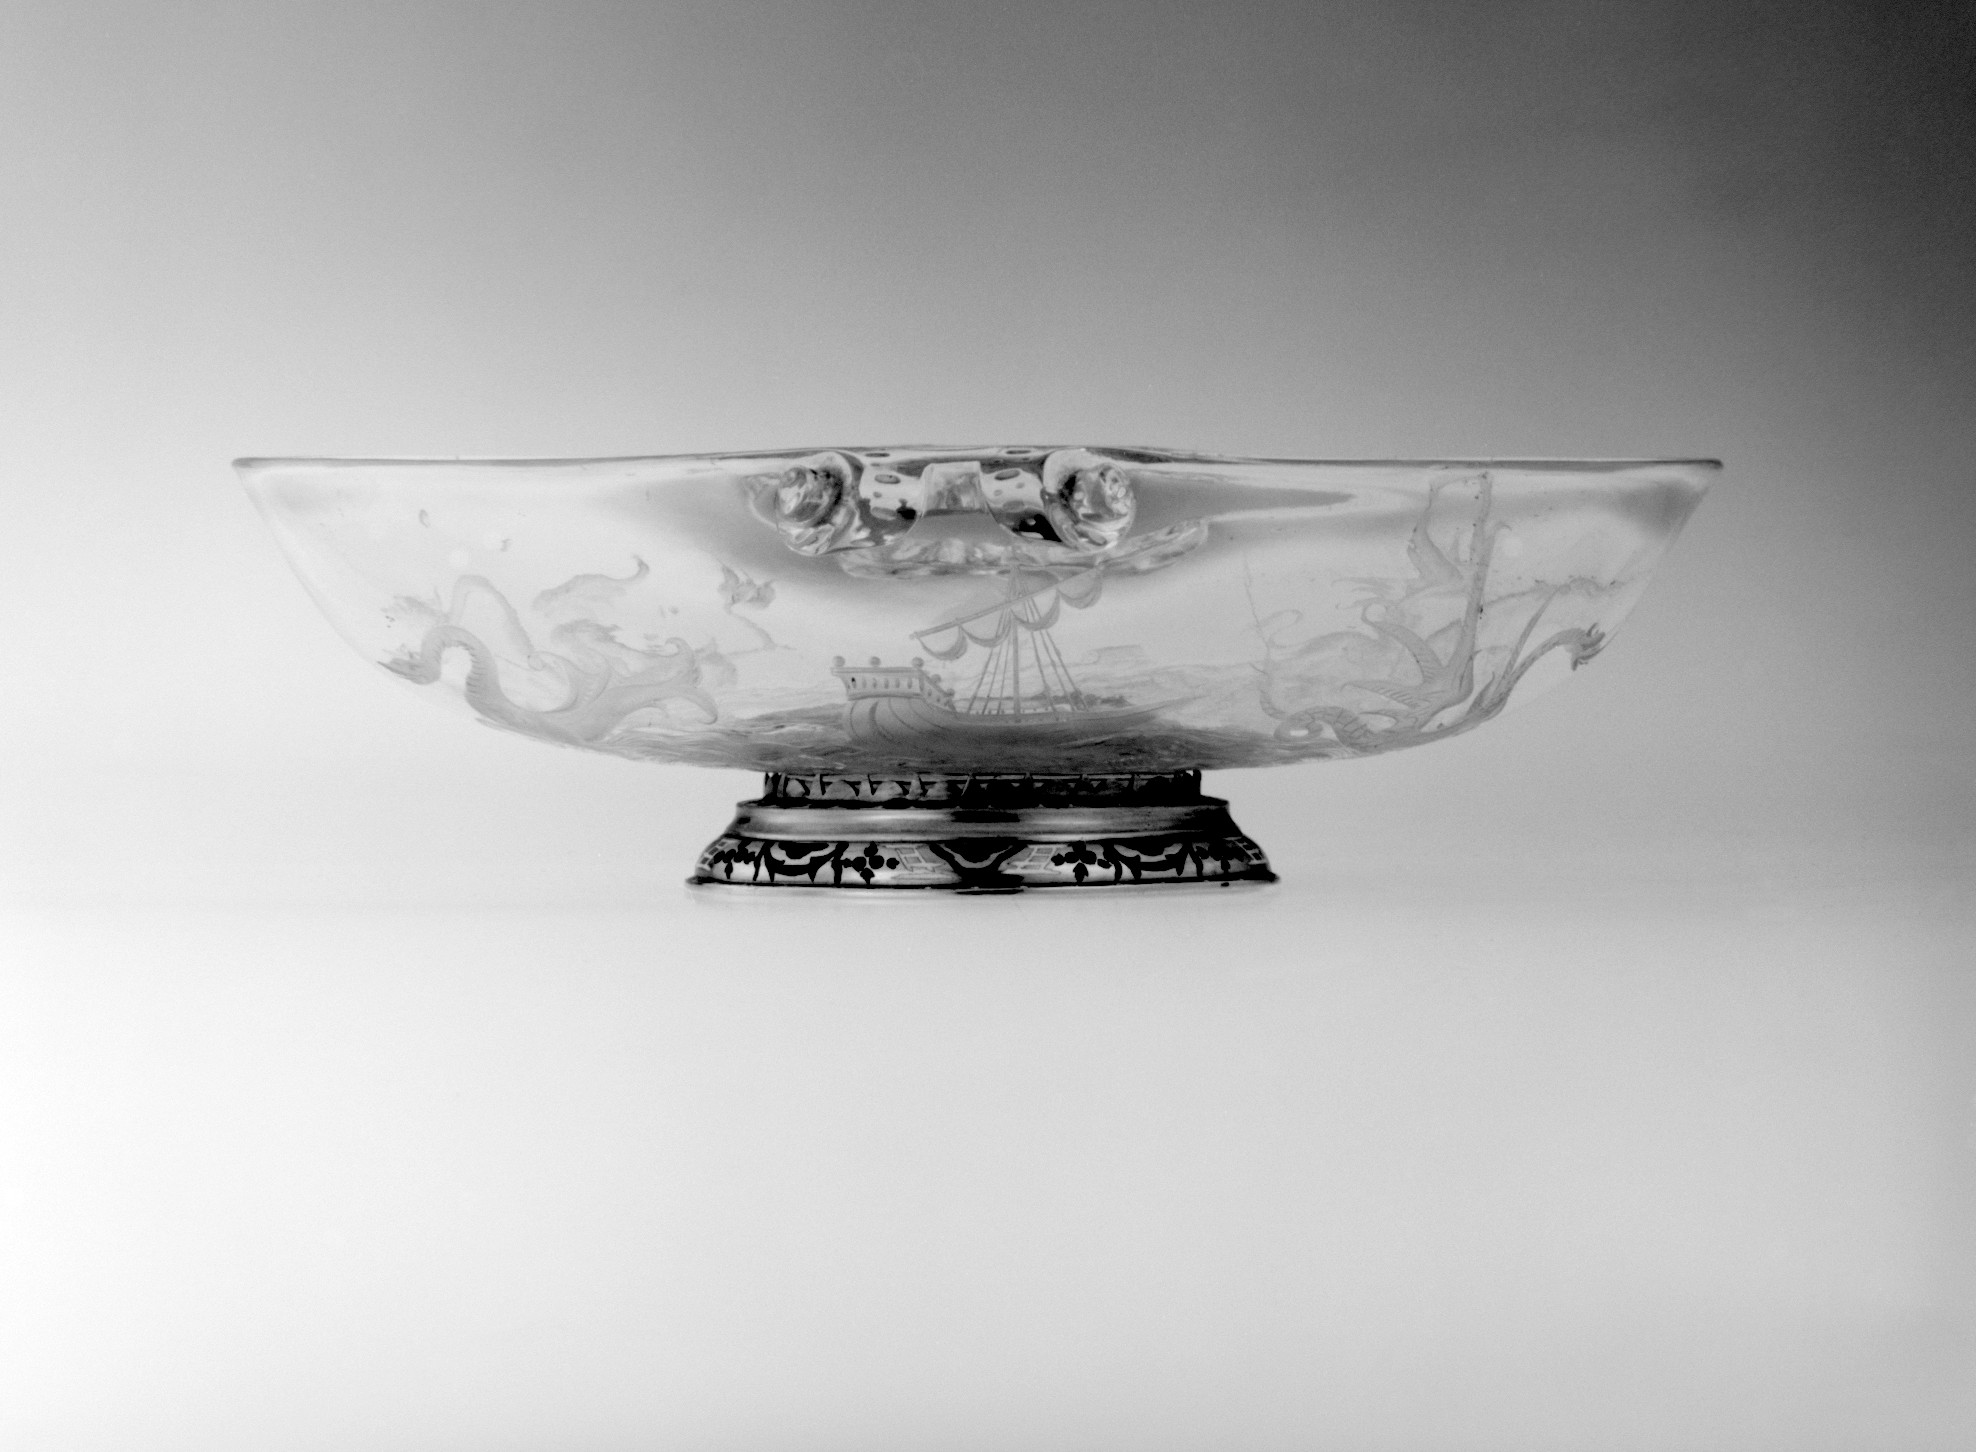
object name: cup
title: Oval cup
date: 1601-1633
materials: gold, quartz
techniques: enamel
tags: monsters,ships